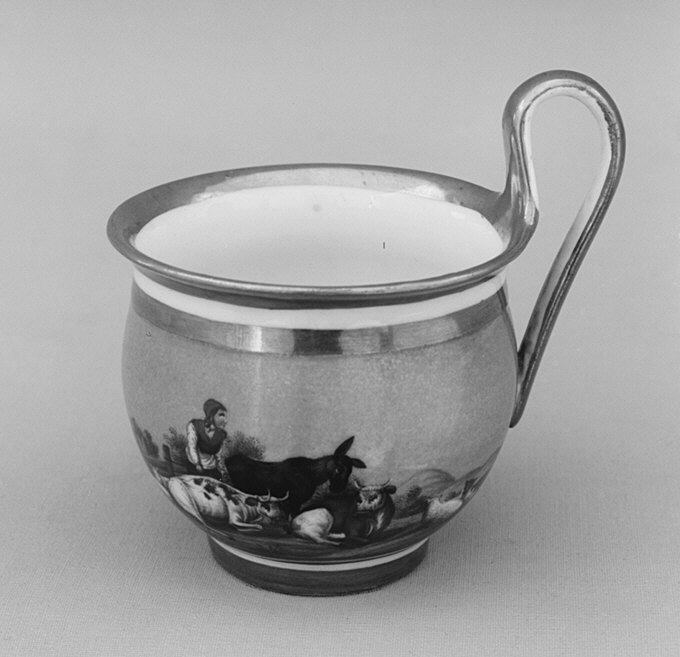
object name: cup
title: Cup (one of six) (part of a set)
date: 1820-1830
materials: hard paste porcelain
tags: men,donkeys